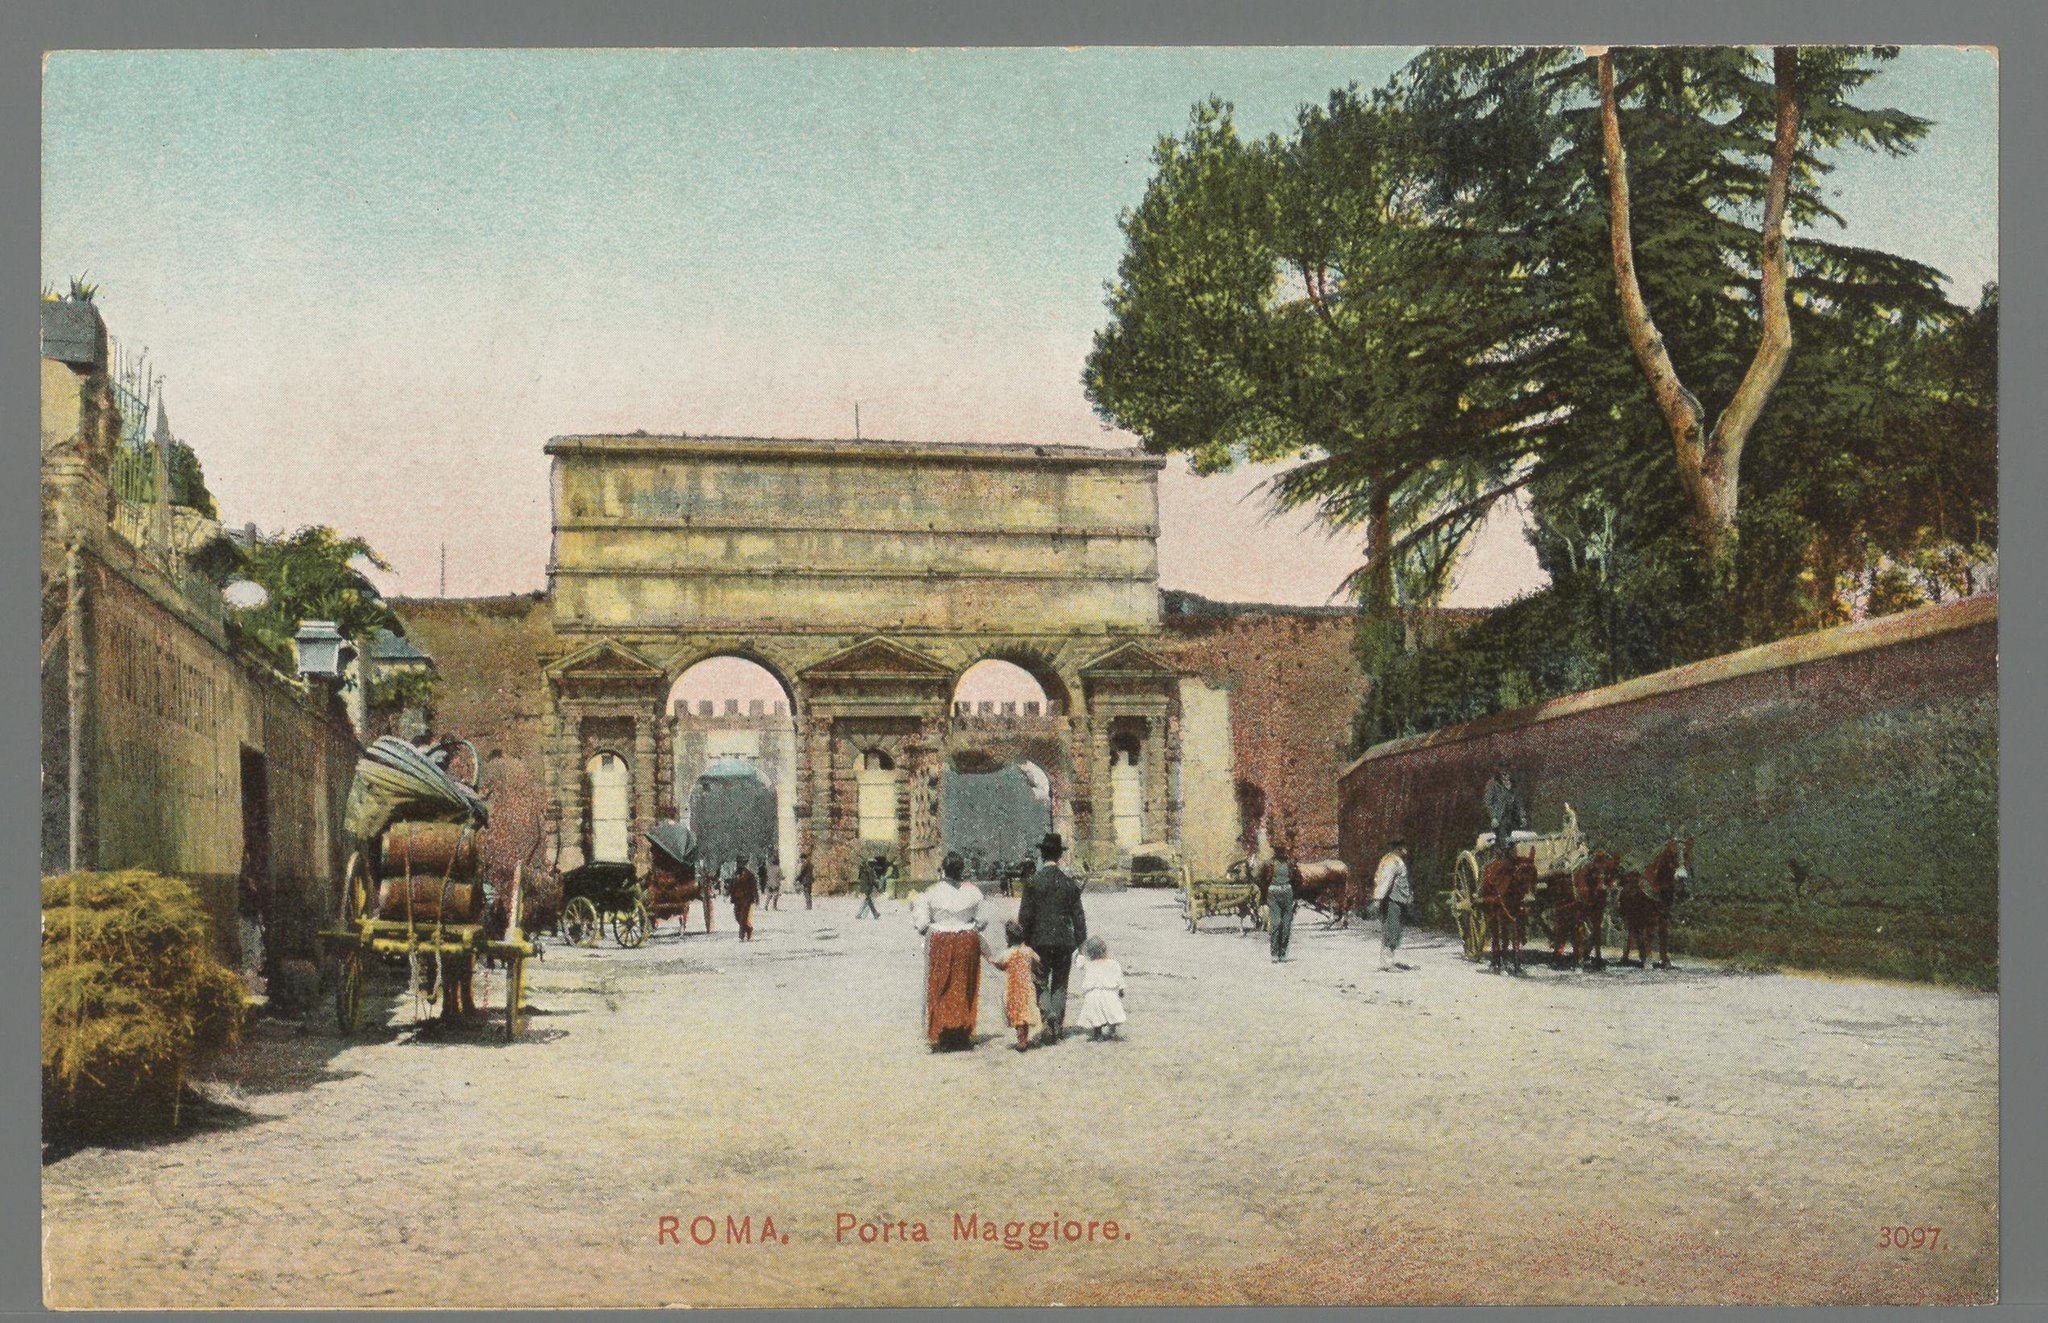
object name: ansichtkaart, prentbriefkaart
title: Roma. Porta Maggiore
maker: Anonymous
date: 1906-1920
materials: cardboard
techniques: lithograph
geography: rome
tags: four-wheeled, animal-drawn vehicle, e.g.: cab, carriage, coach, city-gate (+ city(-scape) with figures, staffage)